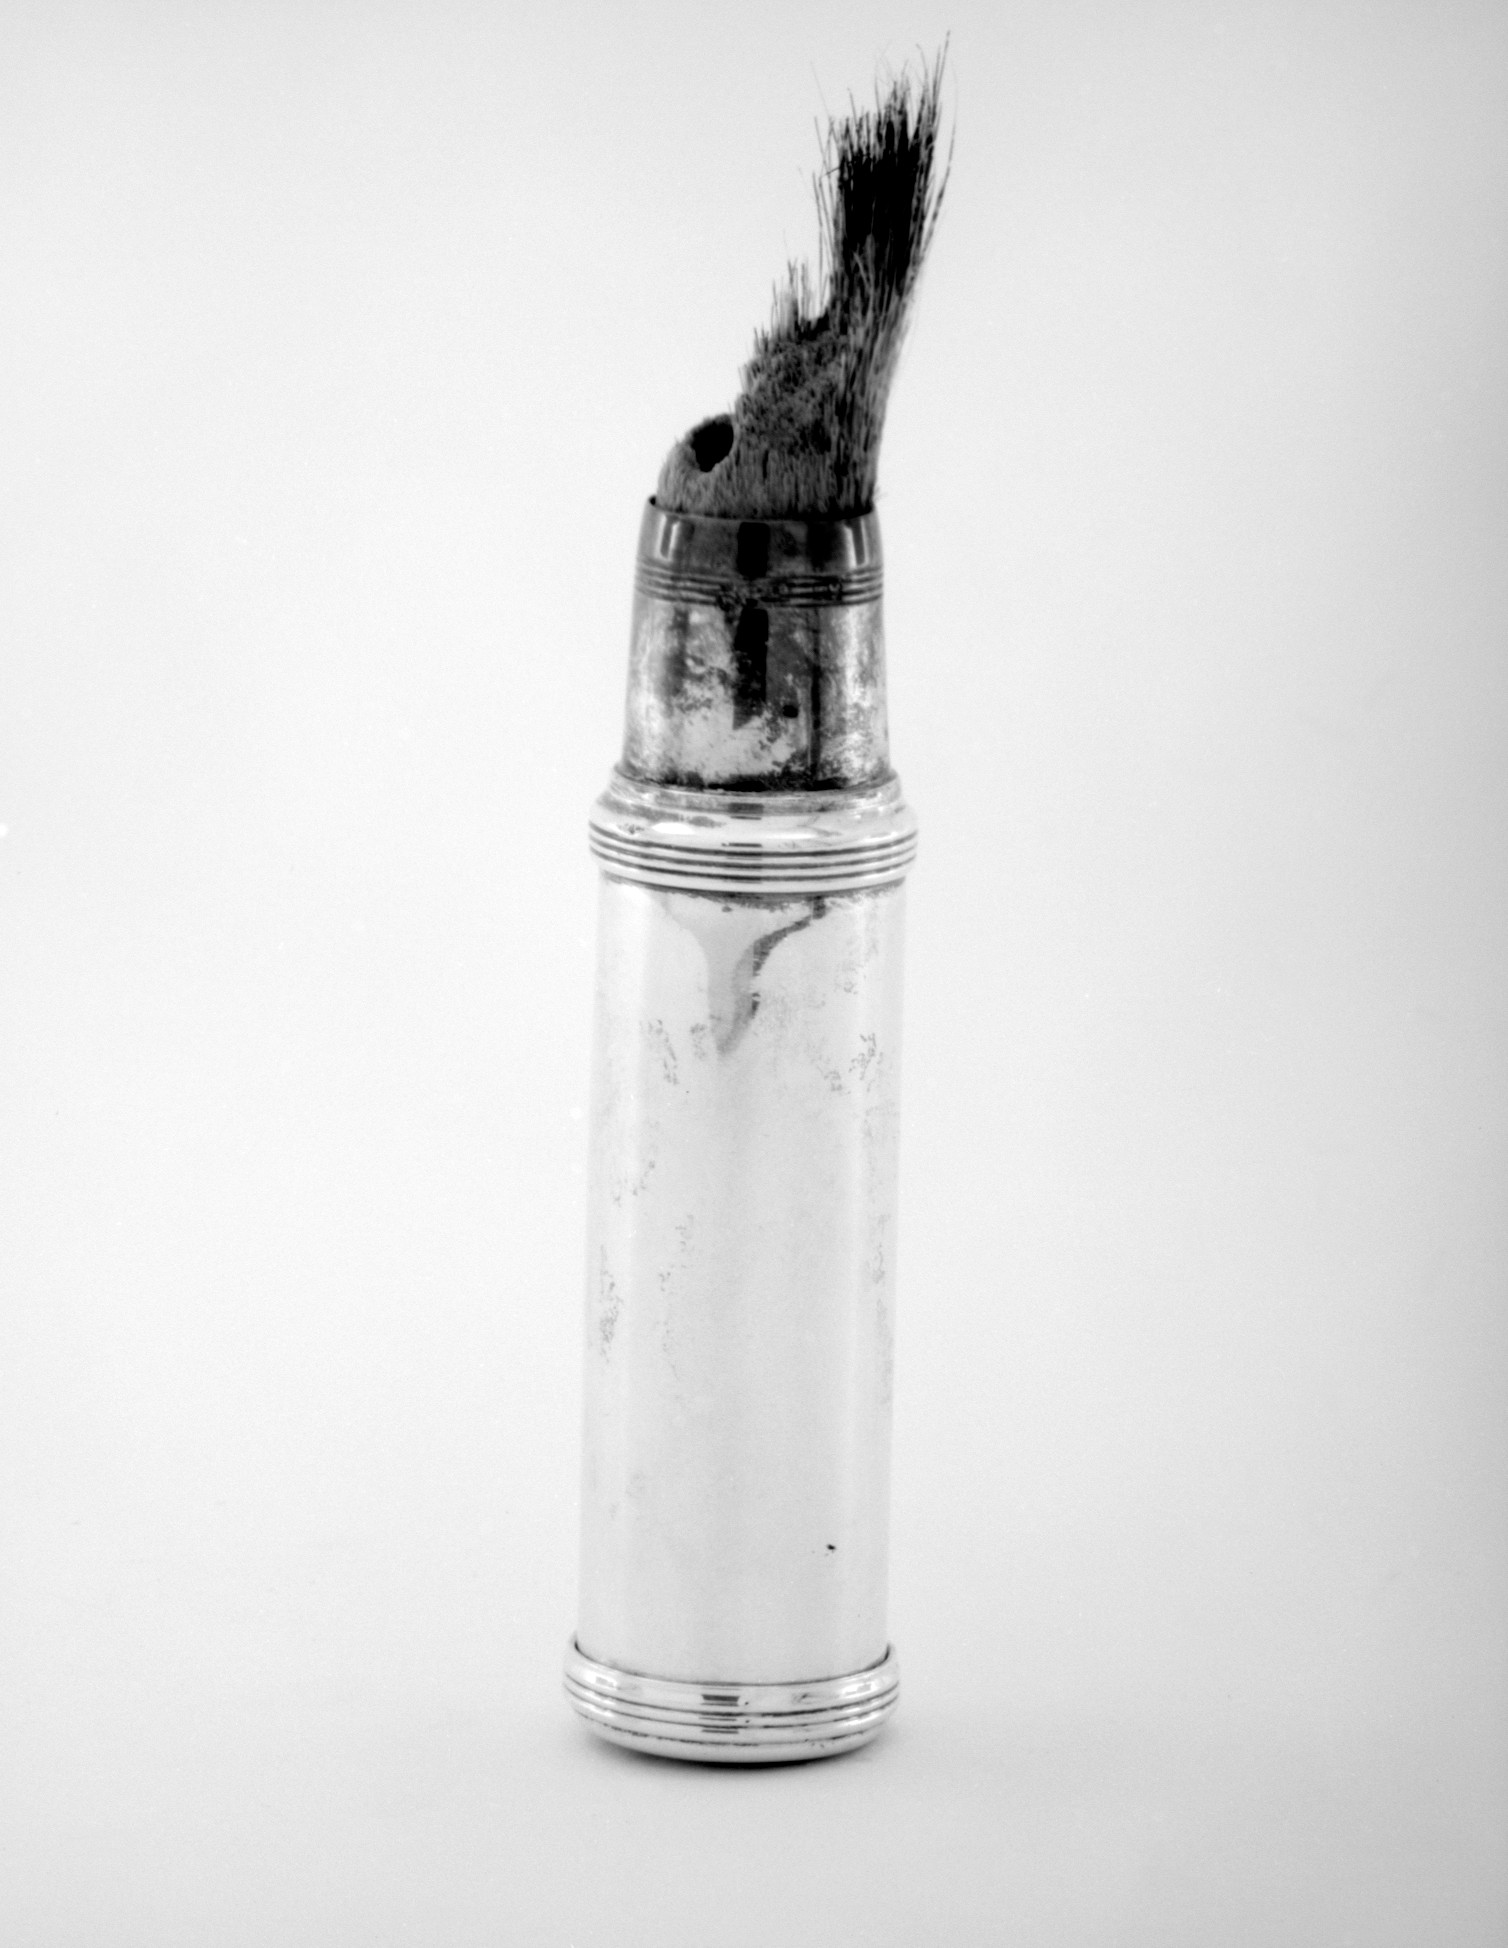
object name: shaving brush with cover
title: Shaving brush with handle and cover (part of a set)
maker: johann bernhard hertz (hentz)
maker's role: maker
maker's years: 1834-1855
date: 1848-1849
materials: silver